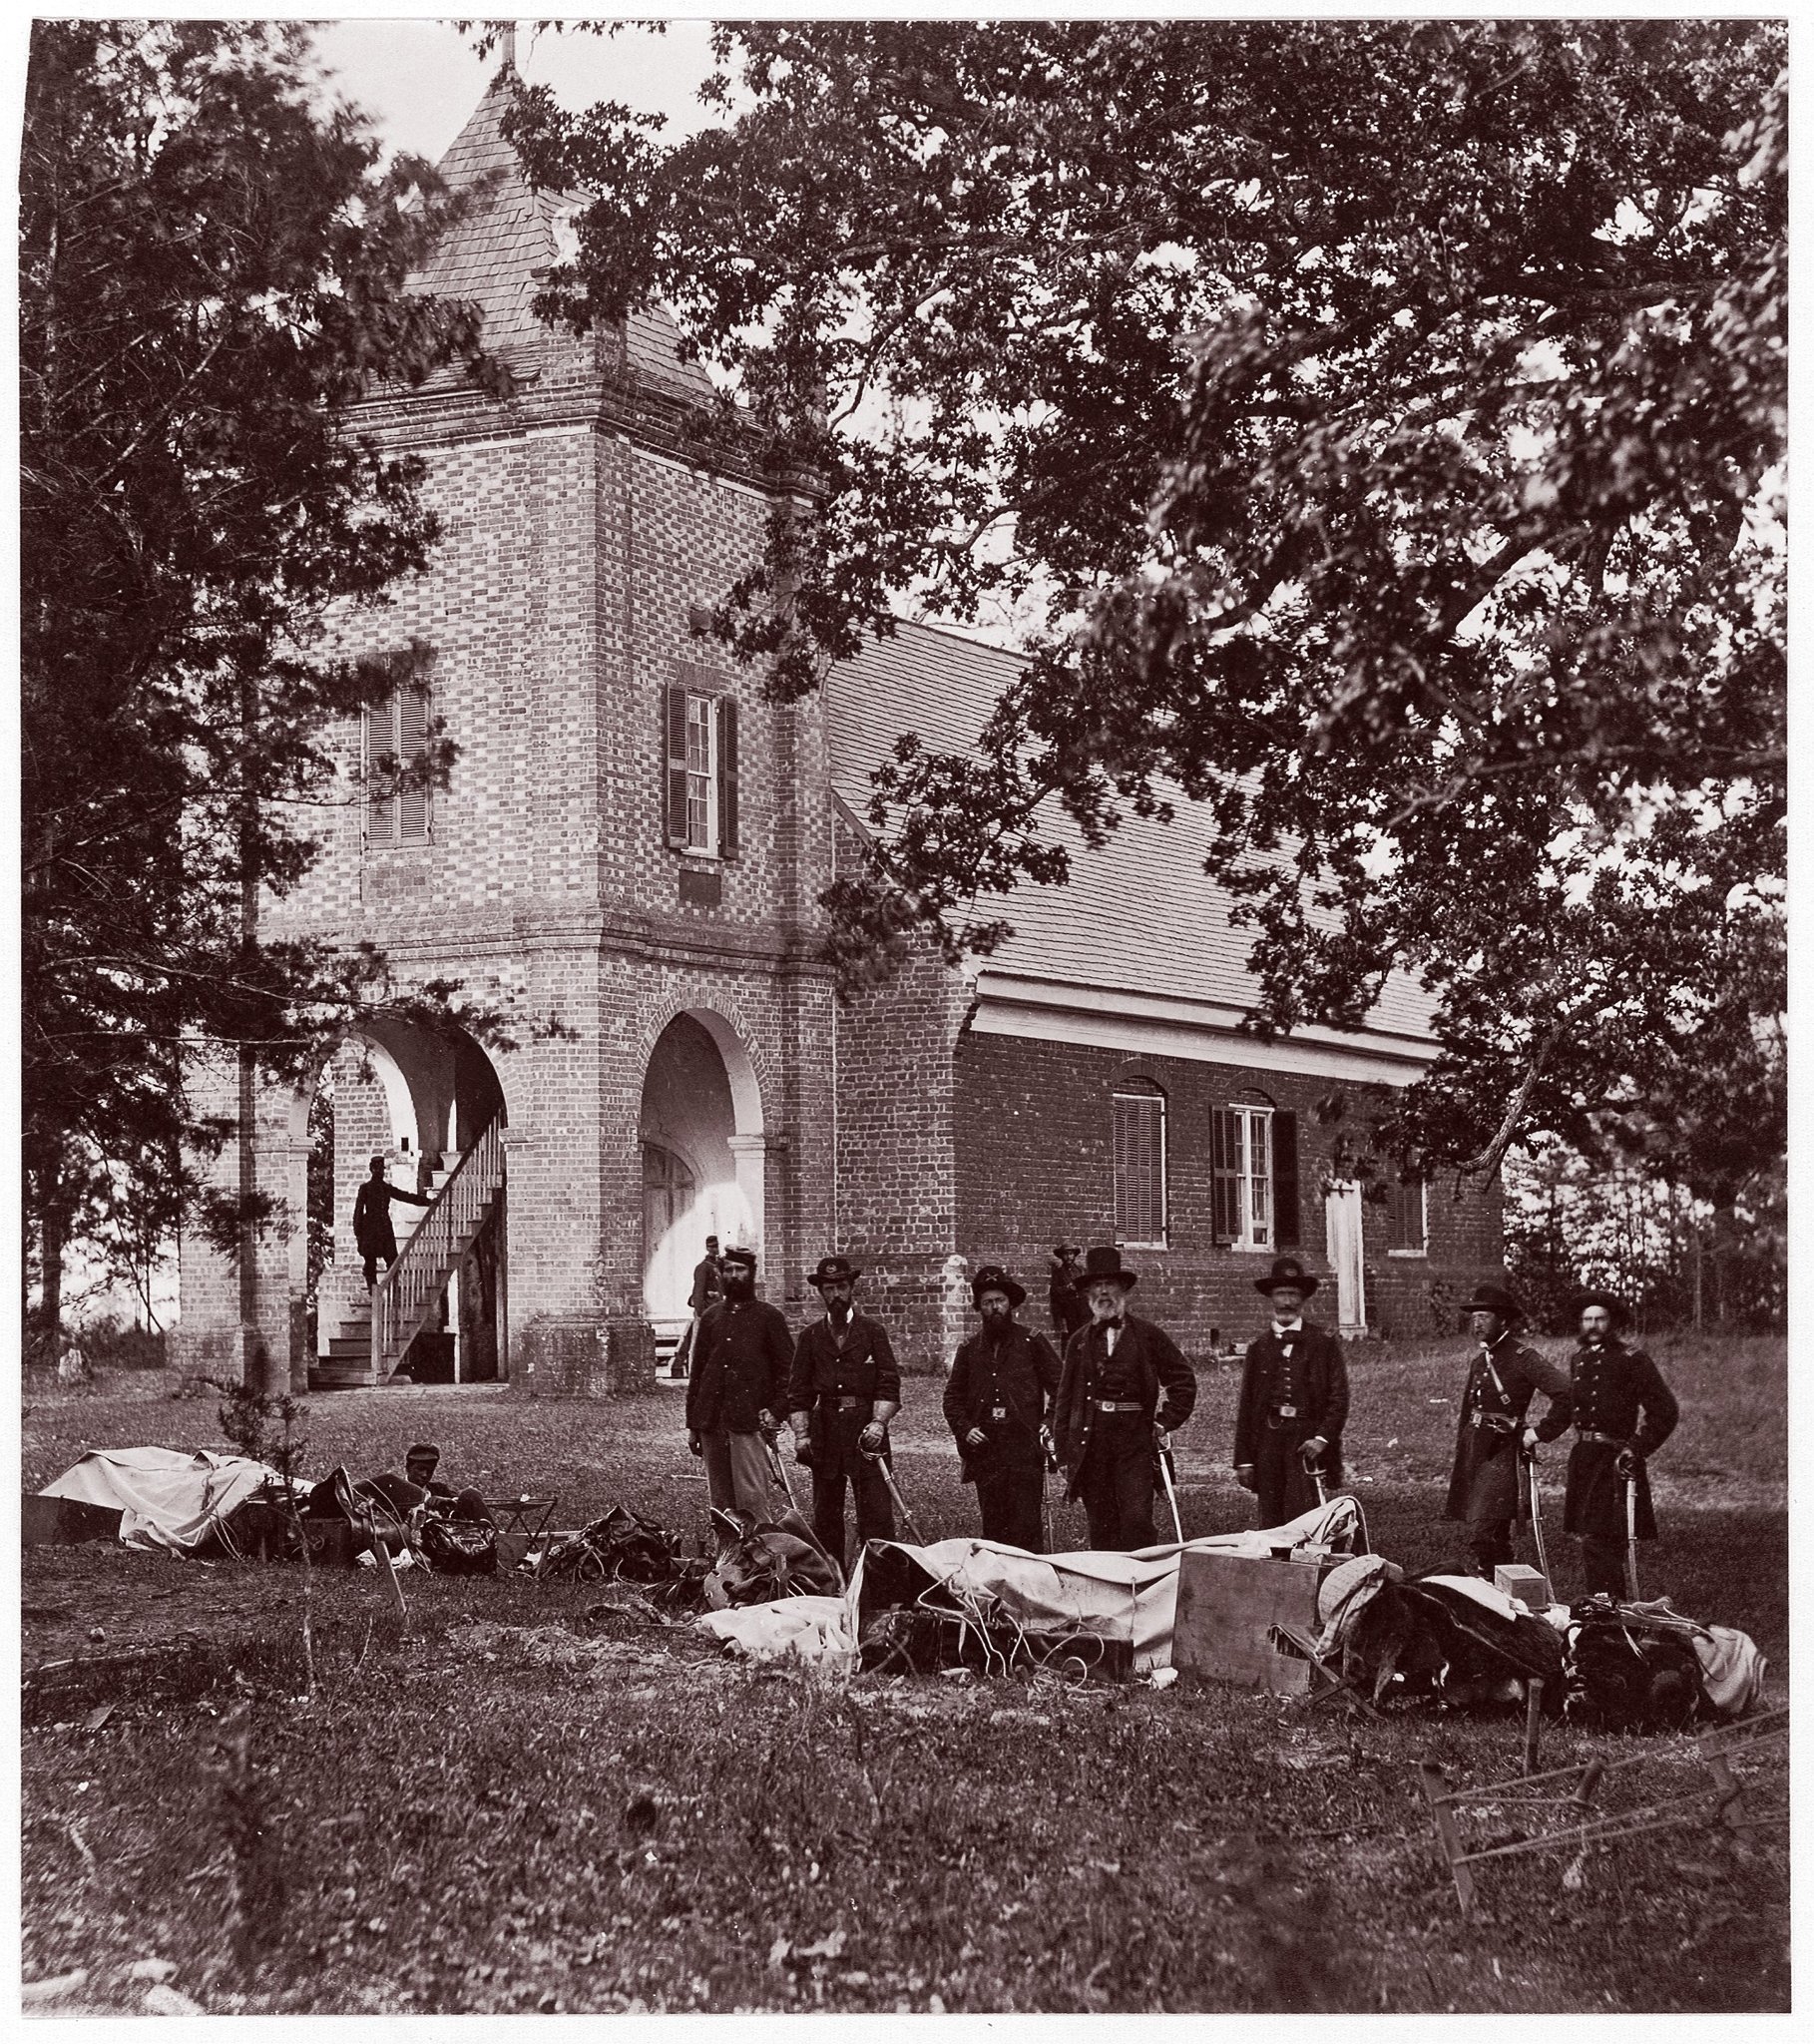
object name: photograph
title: St. Peter's Church near White House, Where Washington was Married. General E. V. Sumner and Staff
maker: alexander gardner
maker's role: artist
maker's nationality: american, scottish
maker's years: 1821-1882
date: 1861-1865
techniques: albumen silver print, glass negative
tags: churches,army,soldiers,american civil war